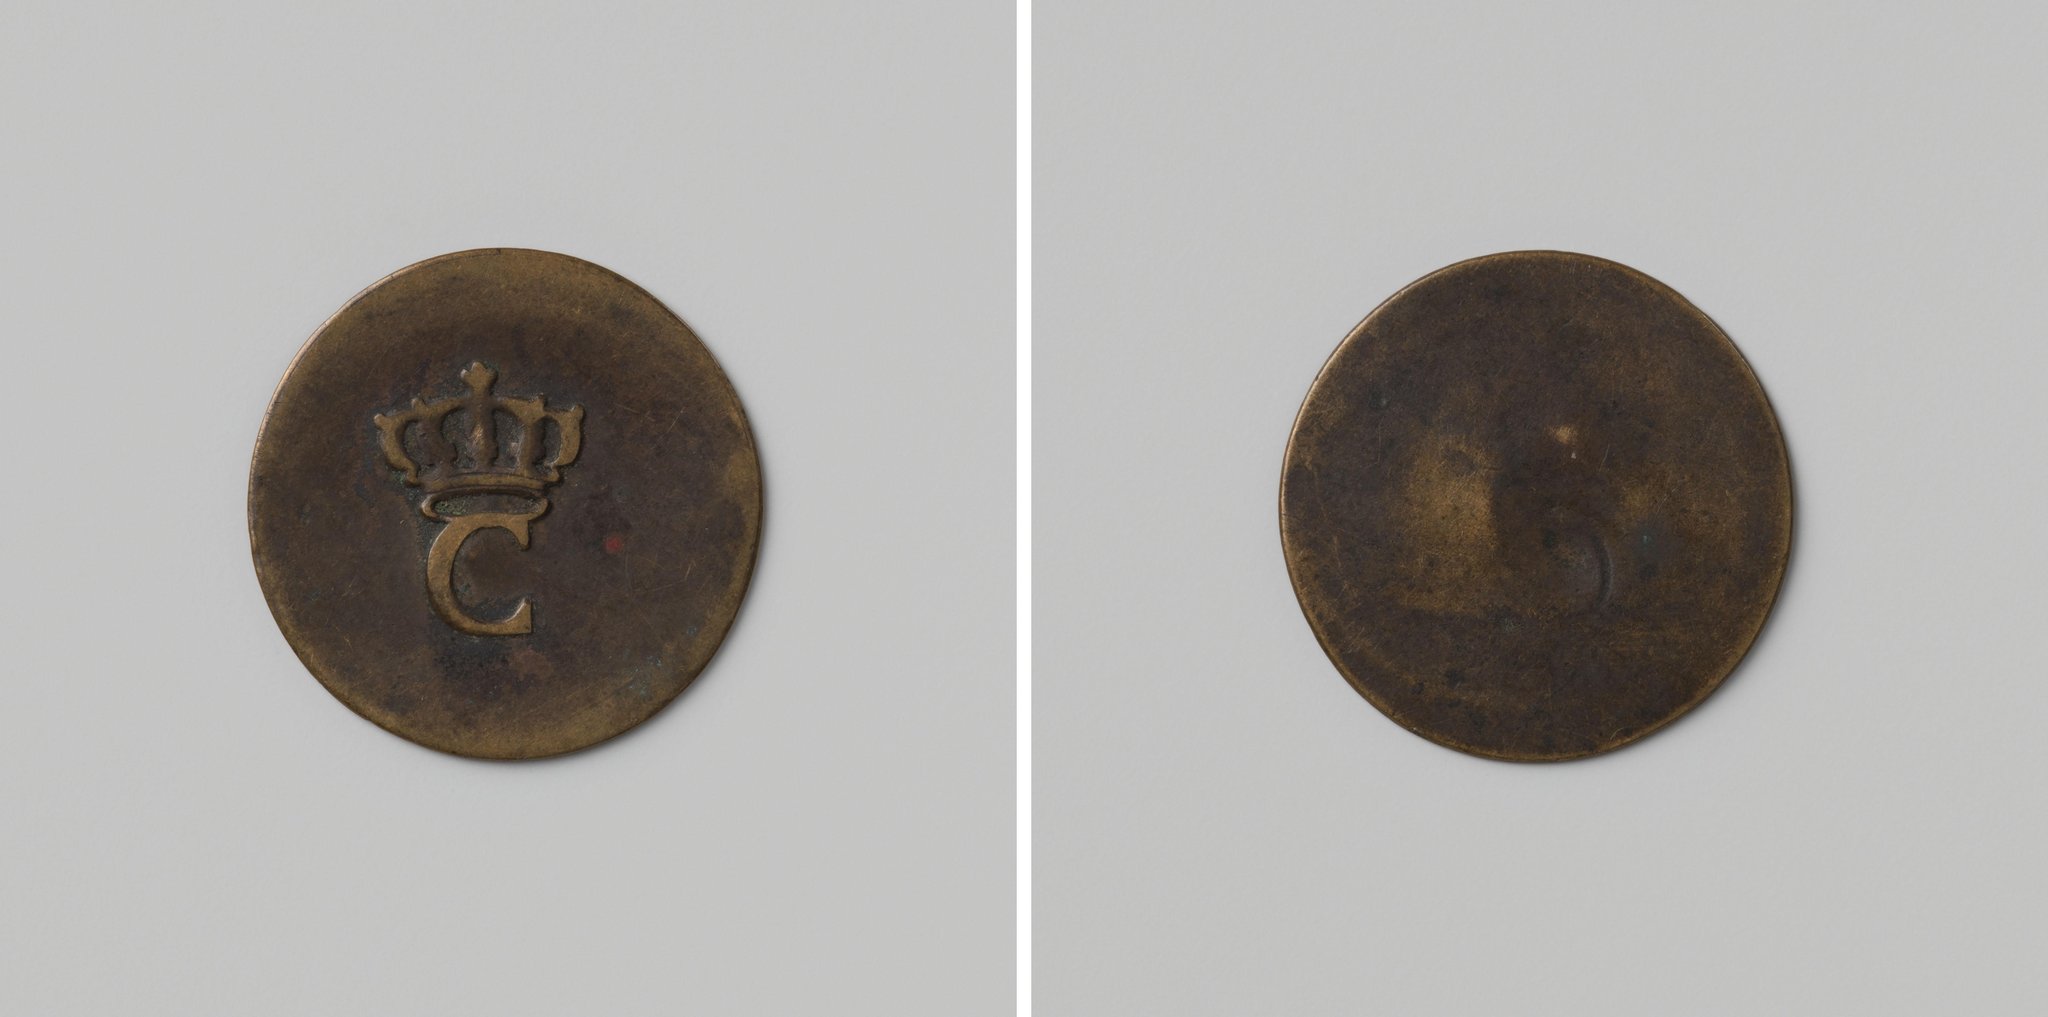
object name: medal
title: Penning met gekroonde letter C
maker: Anonymous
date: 1650-1850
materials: brass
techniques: striking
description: Eenzijdige messing penning. Voorzijde: gekroonde letter C. Keerzijde: blanco